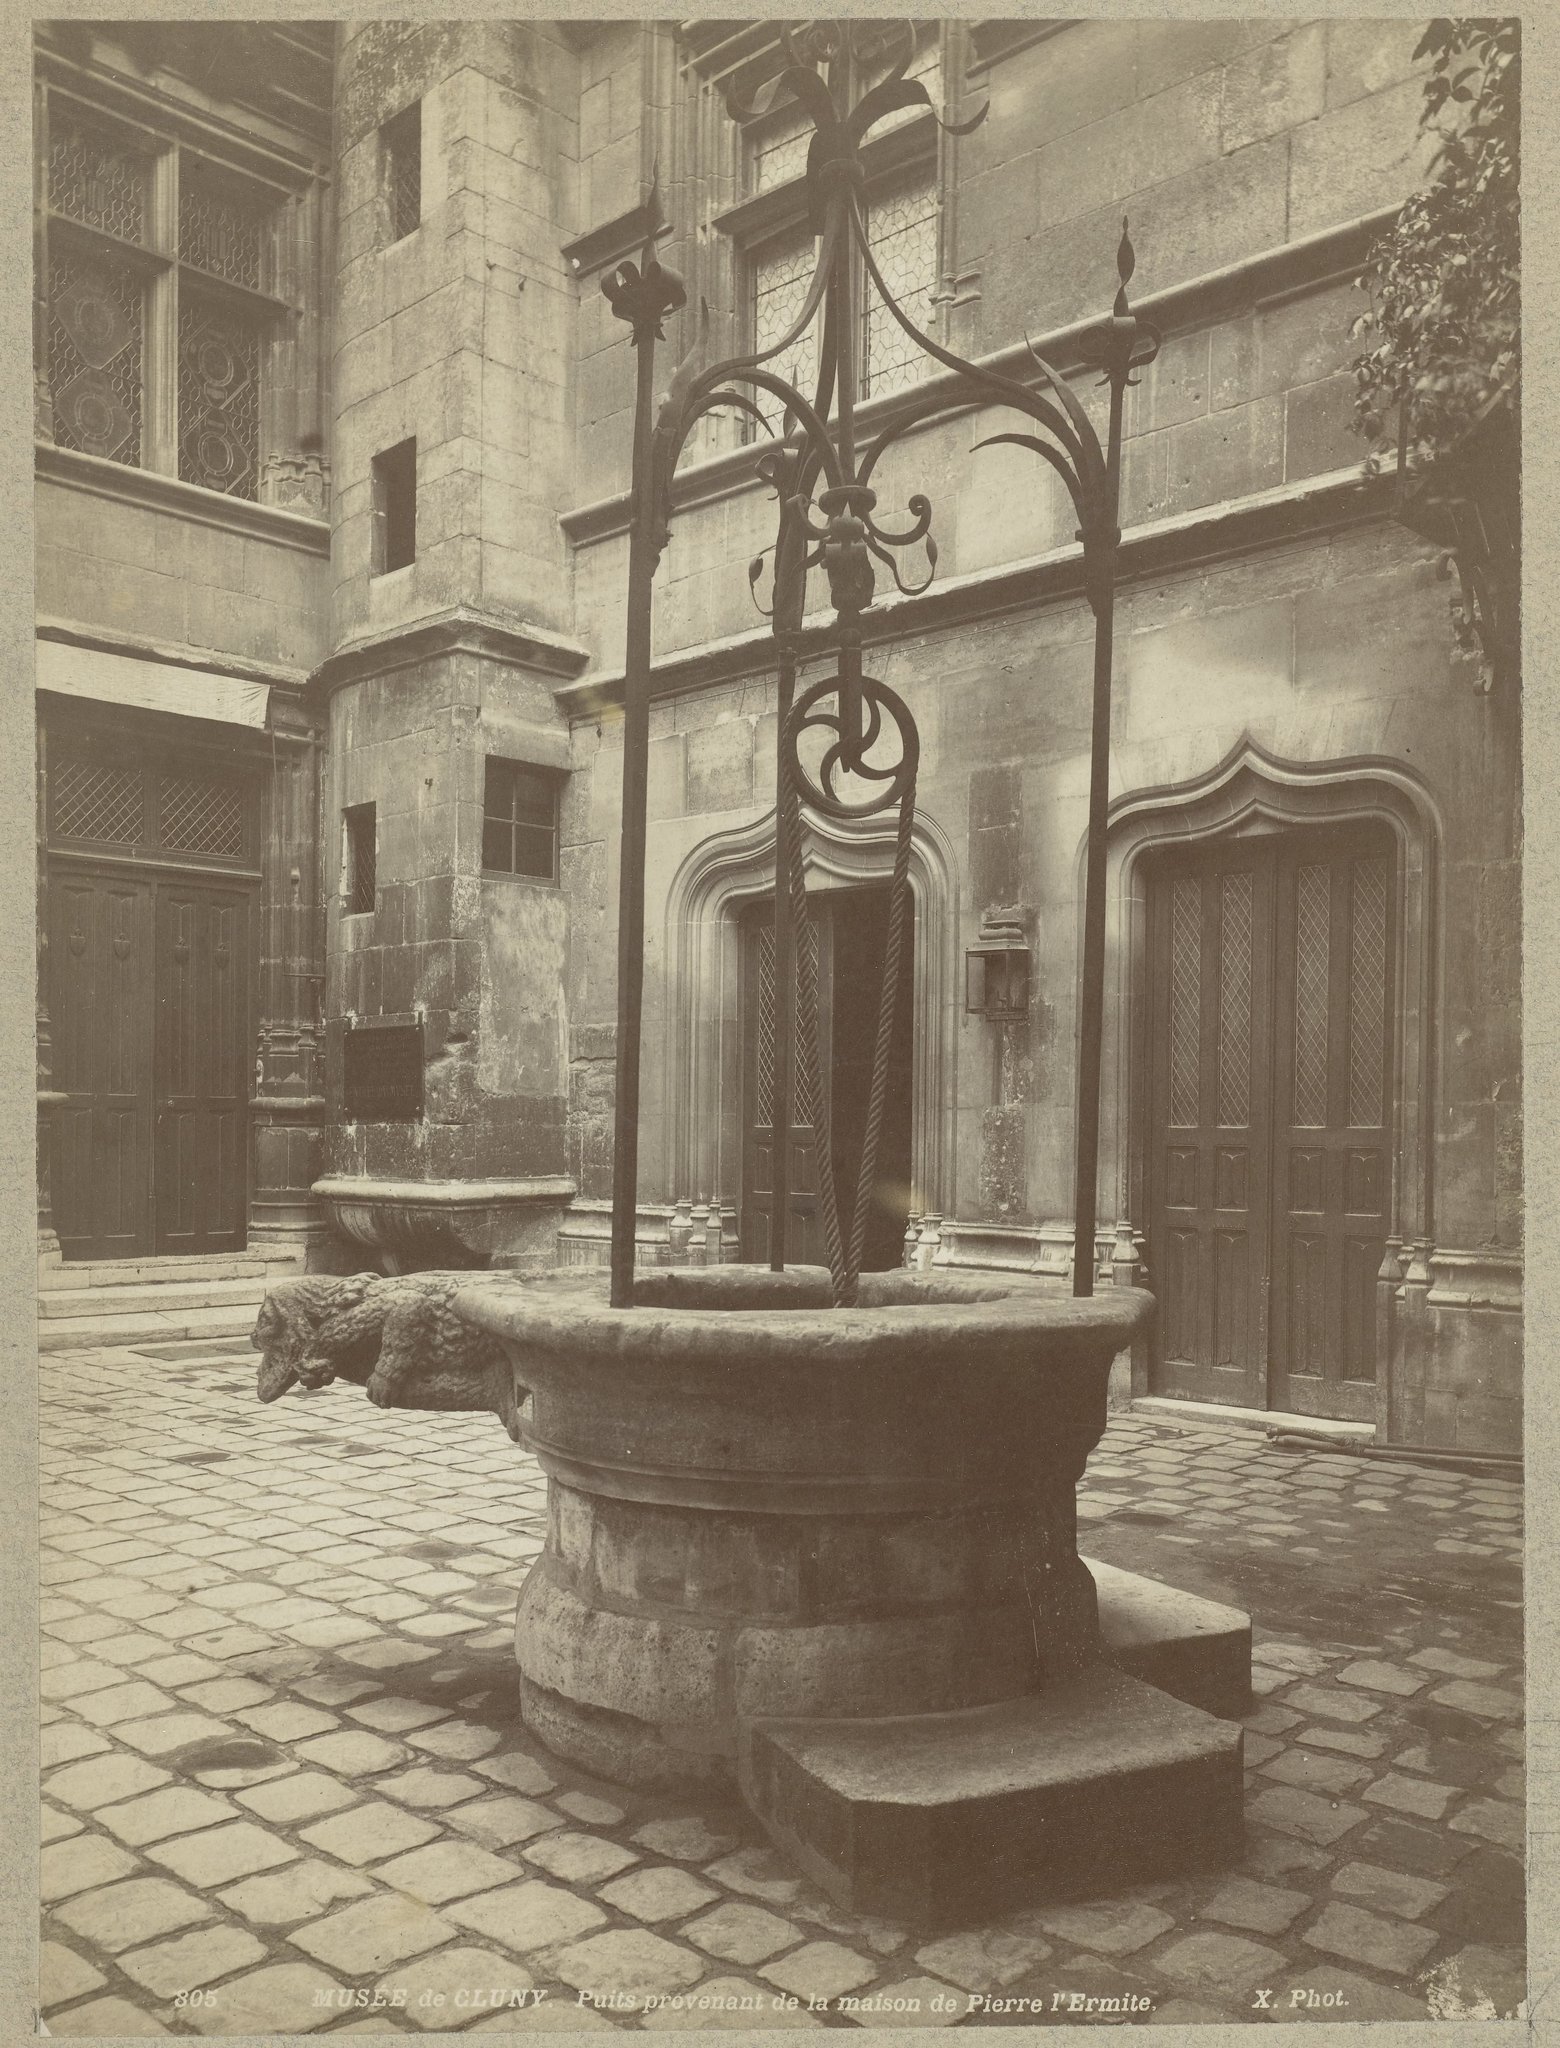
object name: photograph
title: Waterput op de binnenplaats van Musée de Cluny, Parijs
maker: j.a.g. de leur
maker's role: publisher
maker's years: 1860-1914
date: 1887-1894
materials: cardboard, paper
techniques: albumen print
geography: the hague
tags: pump, inner court of palace or 'hôtel'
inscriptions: collector's mark: Lugt 3937, inscription: ‘805 Musée de Cluny. Puits provenant de la maison de Pierre l'Ermite. X. Phot.’, stamp: ‘Kunstboekhandel/ J.A.G. de Leur/ Photograaf-uitgever/ Huigenspark, 40b./ Den Haag.’, inscription: ‘Fr. Gr. Braun.’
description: Tussen 1887 en ca. 1900 werkten Neurdein frères onder andere onder de naam 'X phot.'.